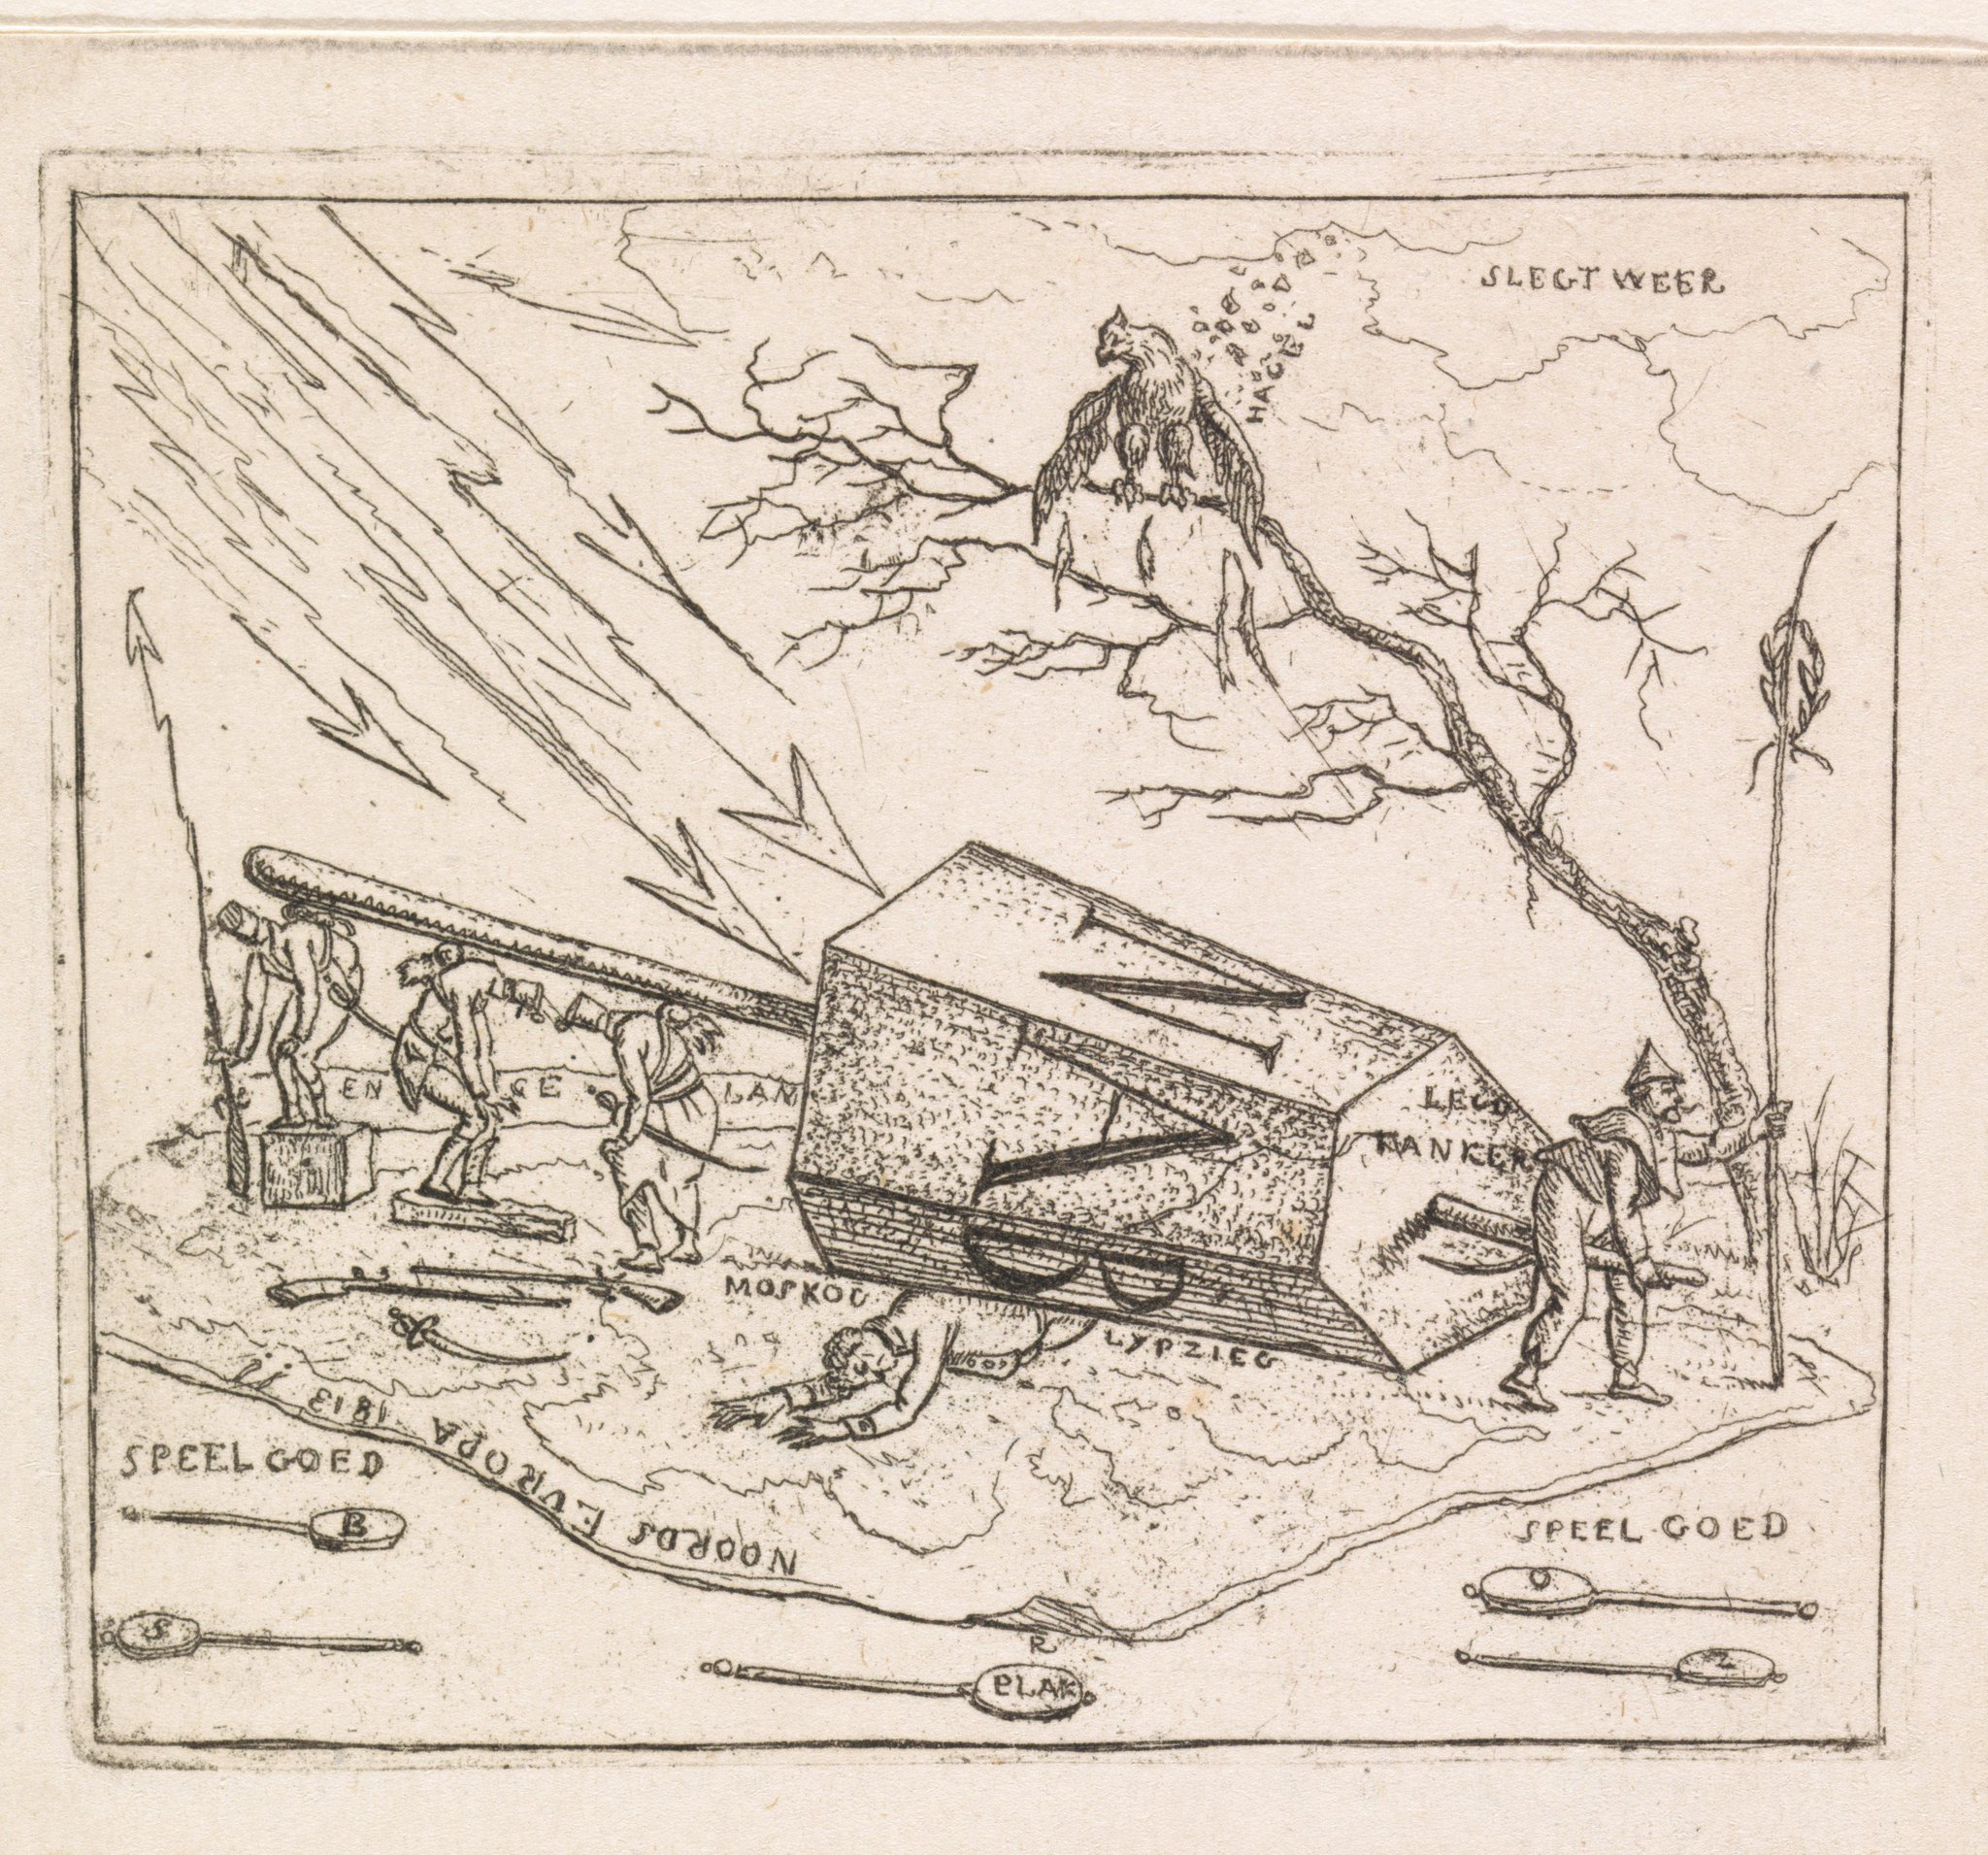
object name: cartoon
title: Napoleon verpletterd onder een zeshoekig blok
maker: hermanus fock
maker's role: conservator, draughtsman, painter, print maker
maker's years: 1766-1822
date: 1812-1813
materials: paper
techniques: etching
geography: netherlands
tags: napoleon i (emperor of the french), (playing with) top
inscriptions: collector's mark: Lugt 2228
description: Op een kaart van Noord-Europa waarop aangegeven Moskou en Leipzig ligt Napoleon verpletterd onder een 'alletje', een zeshoekig tolletje met een letter op elke zijde. Zichtbaar zijn de letters: NAB. De Franse adelaar zit zwaar gehavend door het slechte weer in een boom. De Franse soldaten proberen de tol op te tillen. Vanuit de hemel schieten bliksemschichten. Op de voorgrond liggen lepels of plakken met letters van de landen die Frankrijk bij Leipig of in Rusland straften.